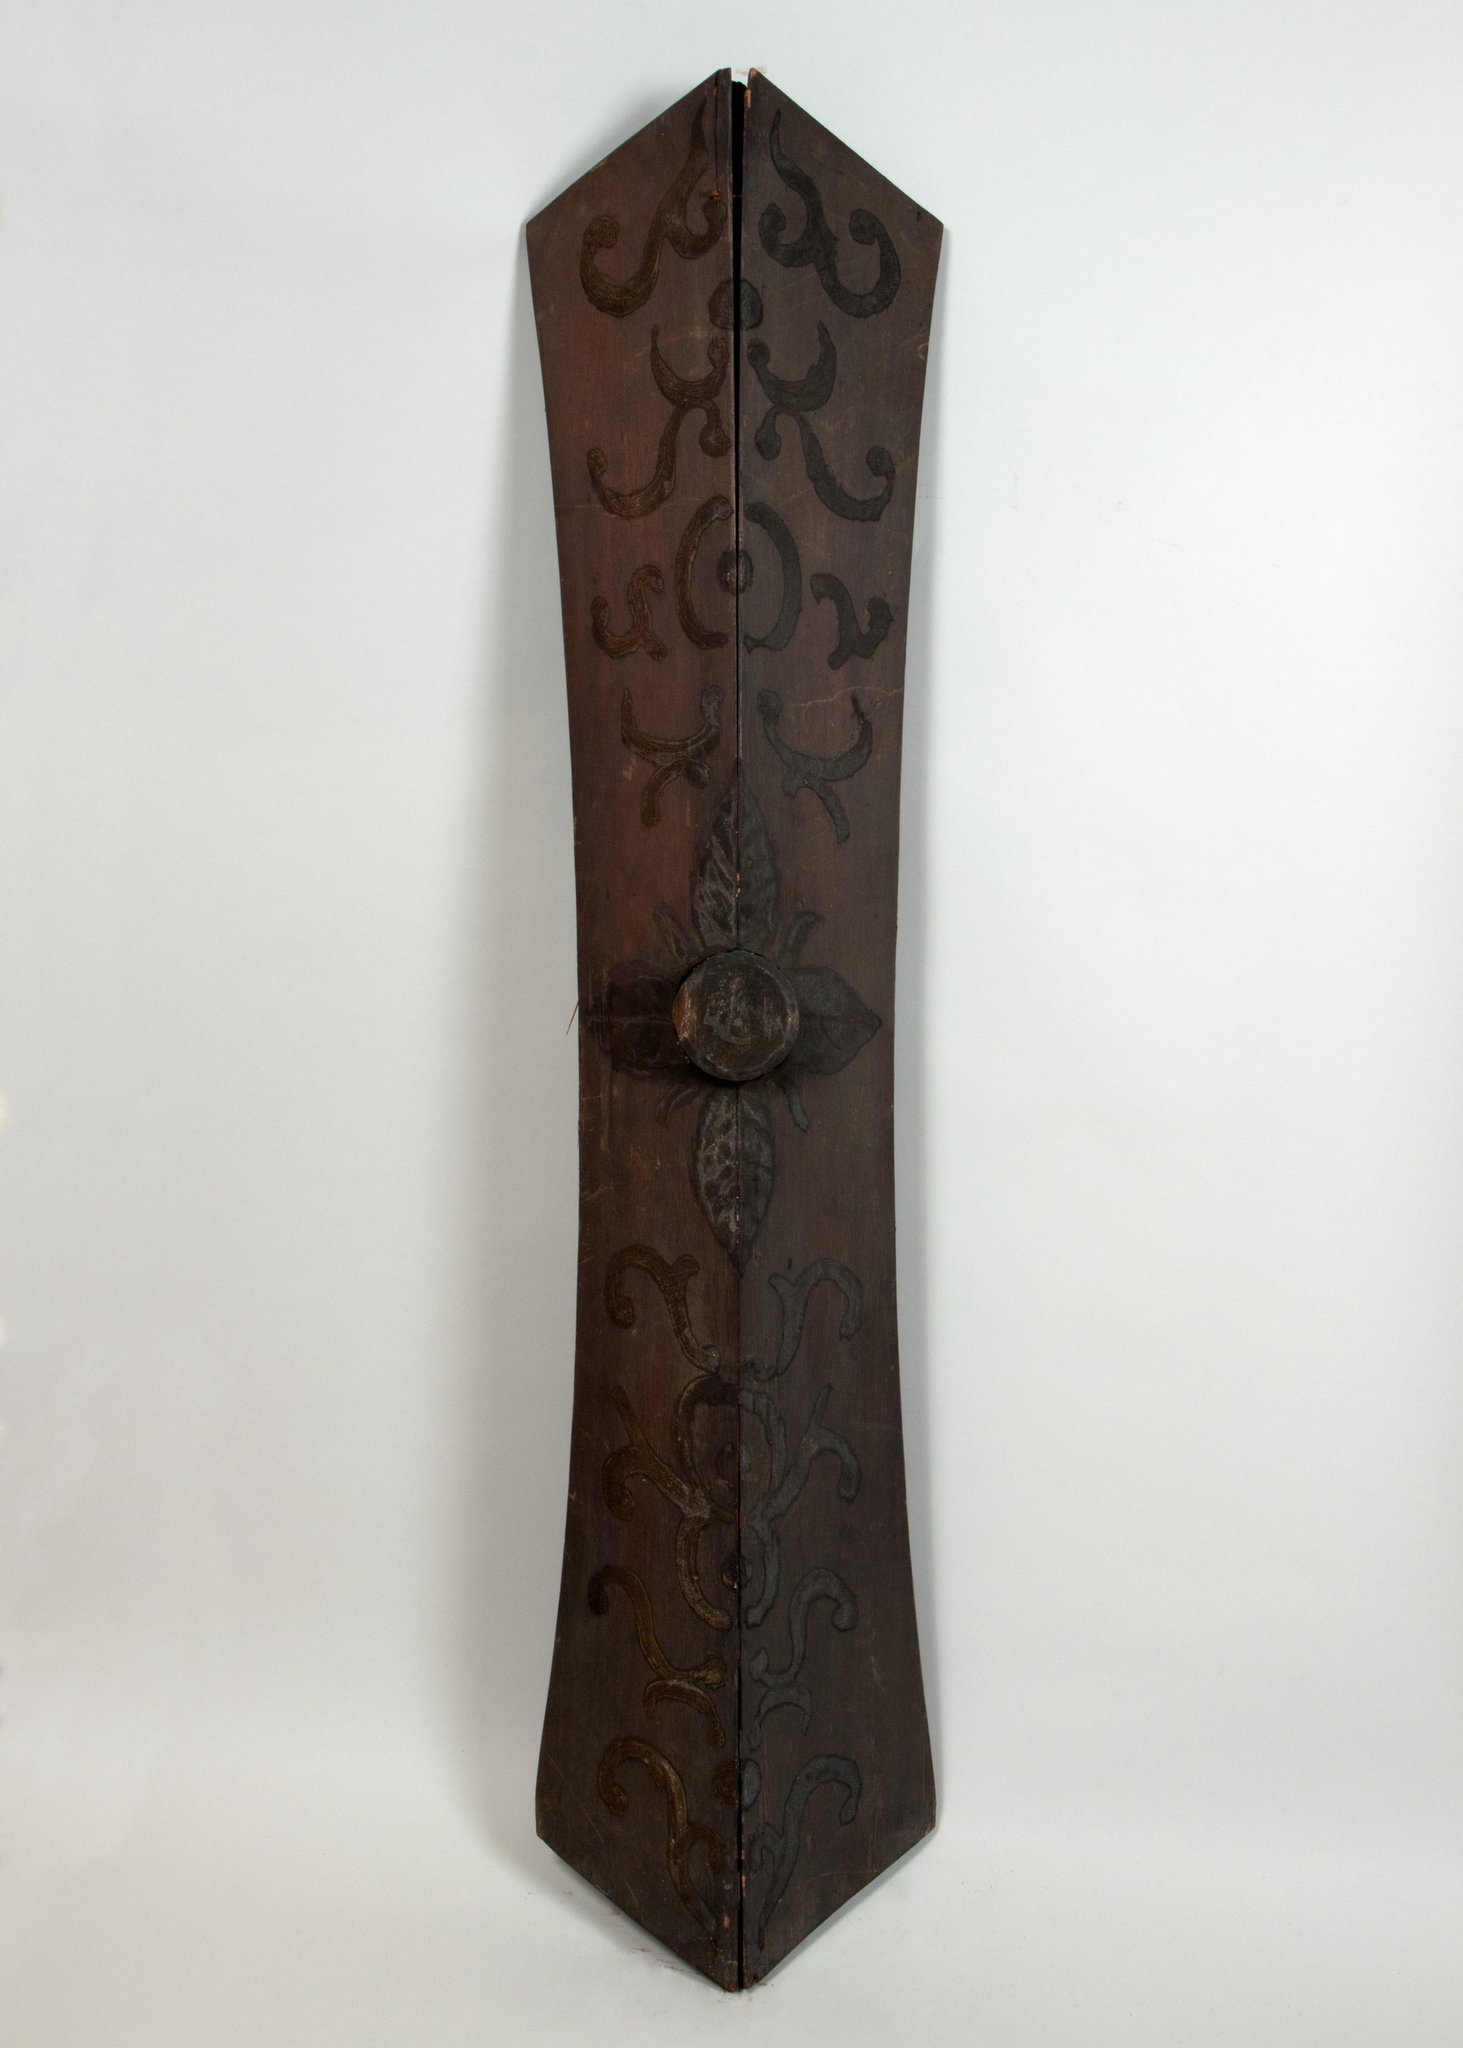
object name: shield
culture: indonesian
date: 1701-1900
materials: wood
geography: indonesia